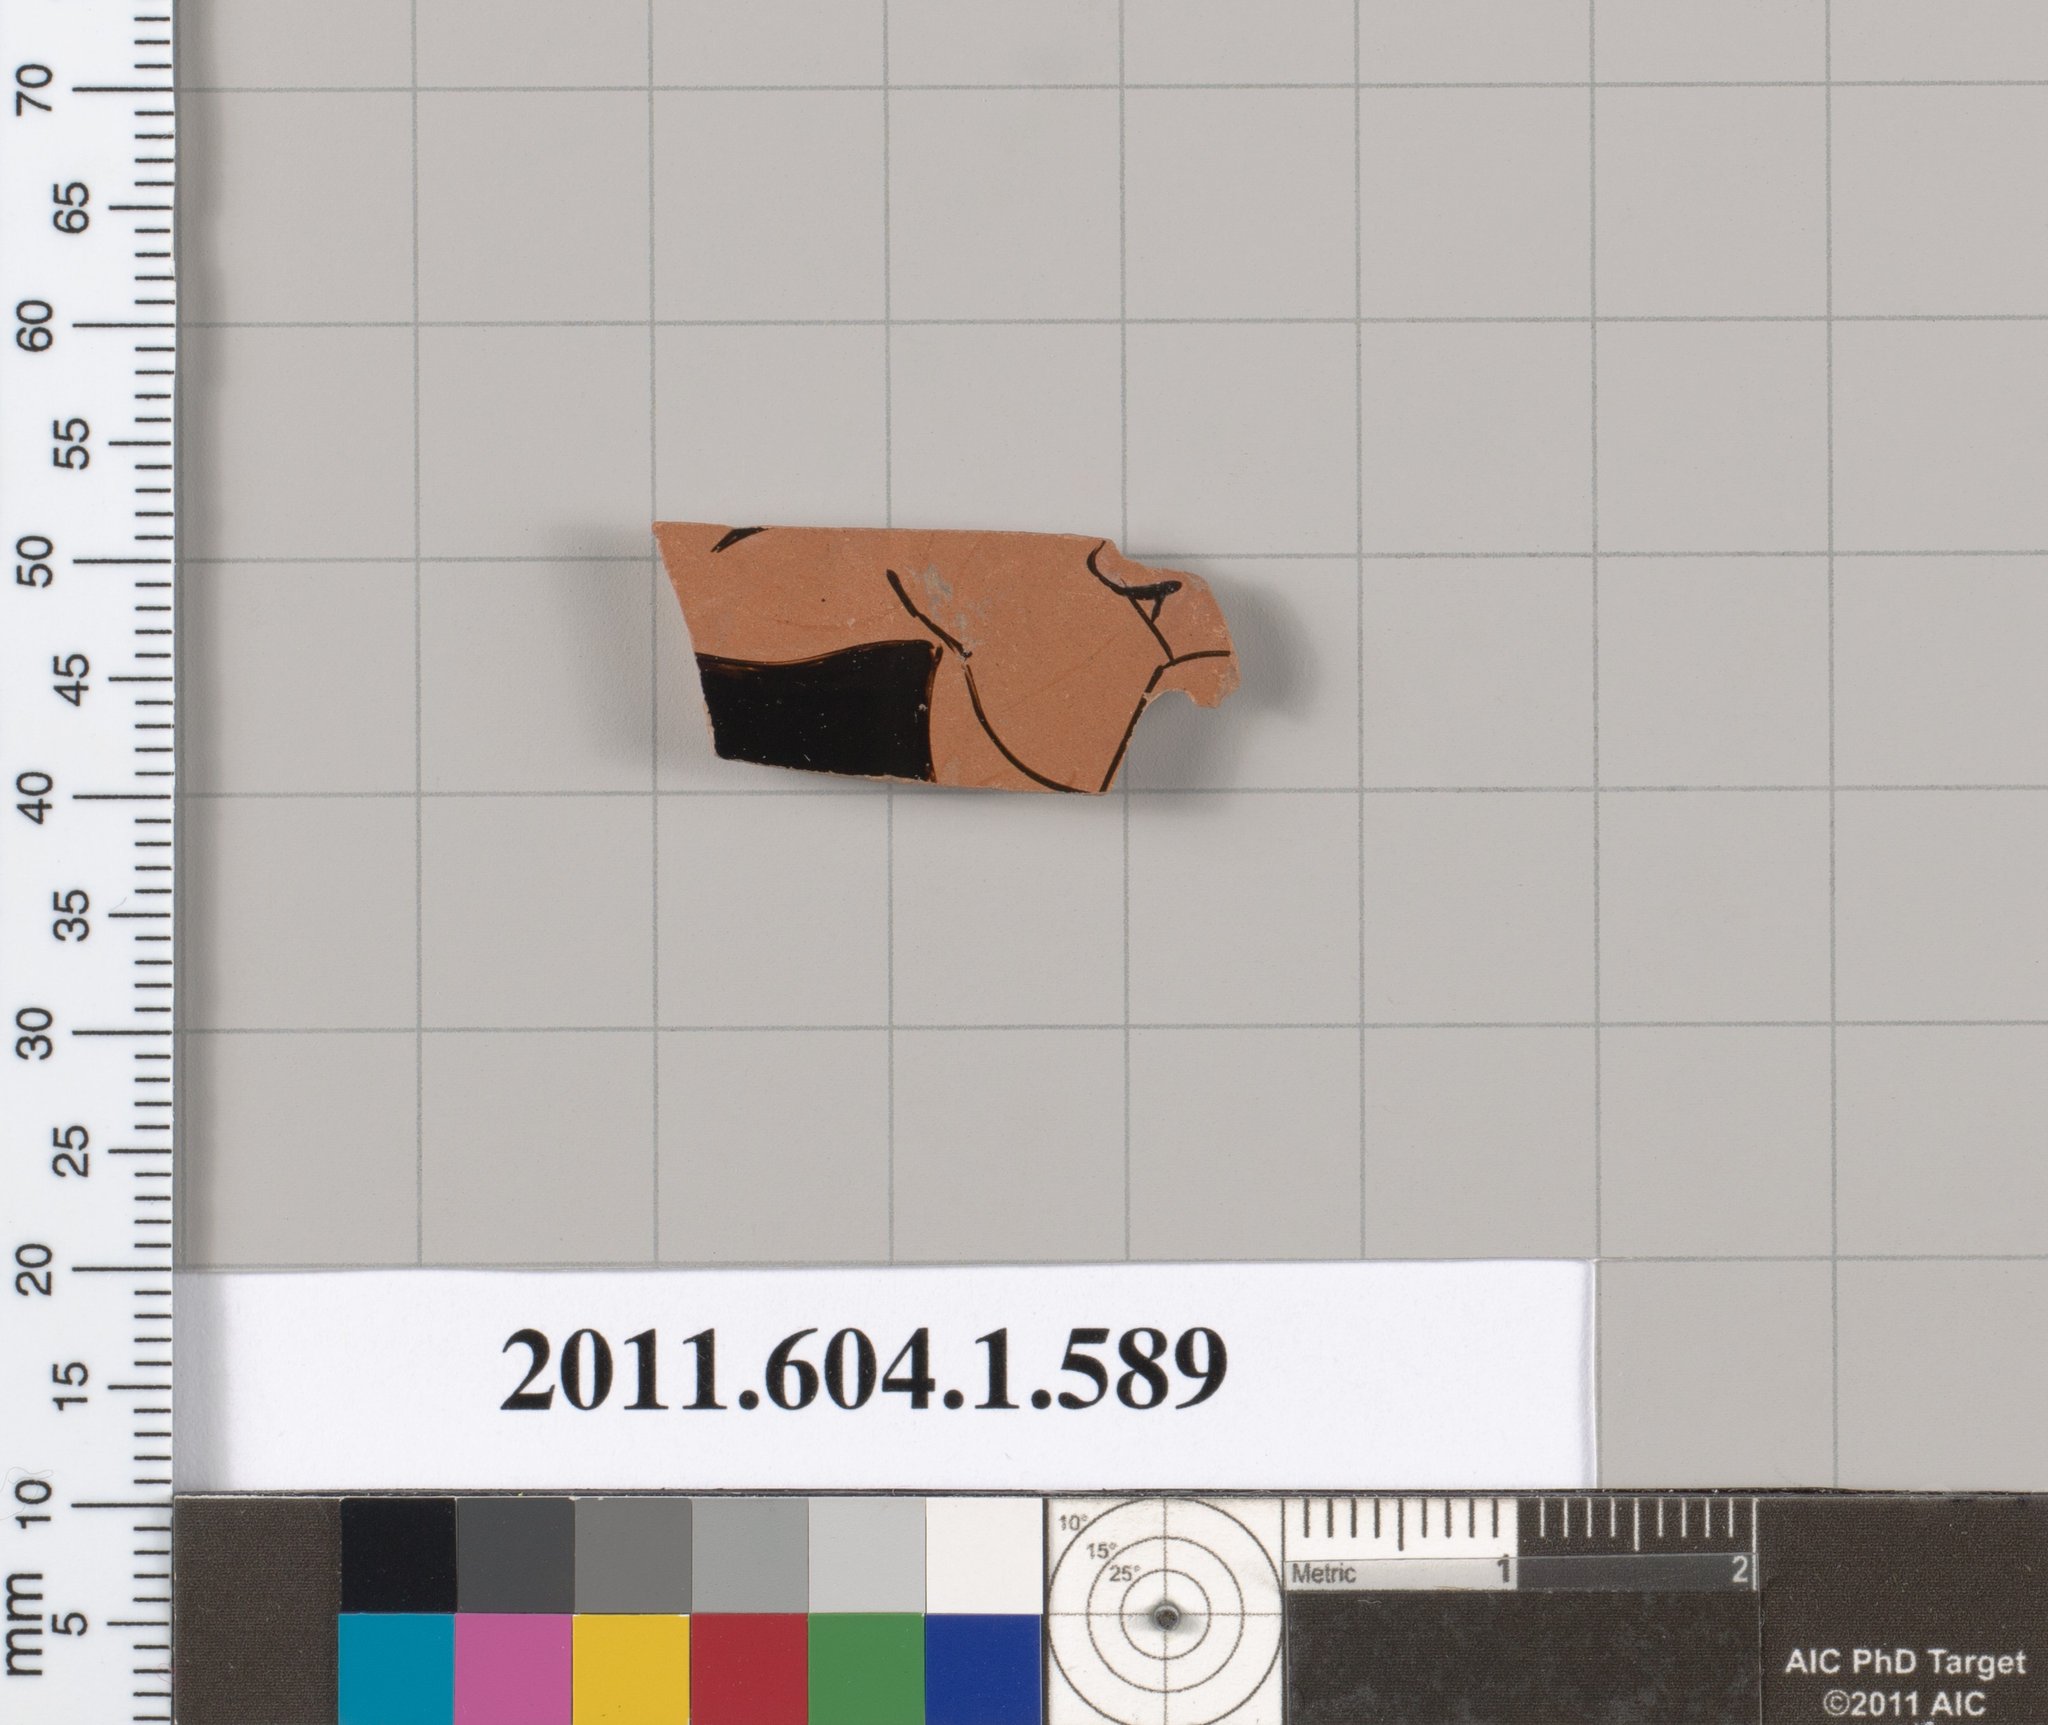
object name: kylix fragment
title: Terracotta fragment of a kylix (drinking cup)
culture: greek, attic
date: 475-451 BCE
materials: terracotta